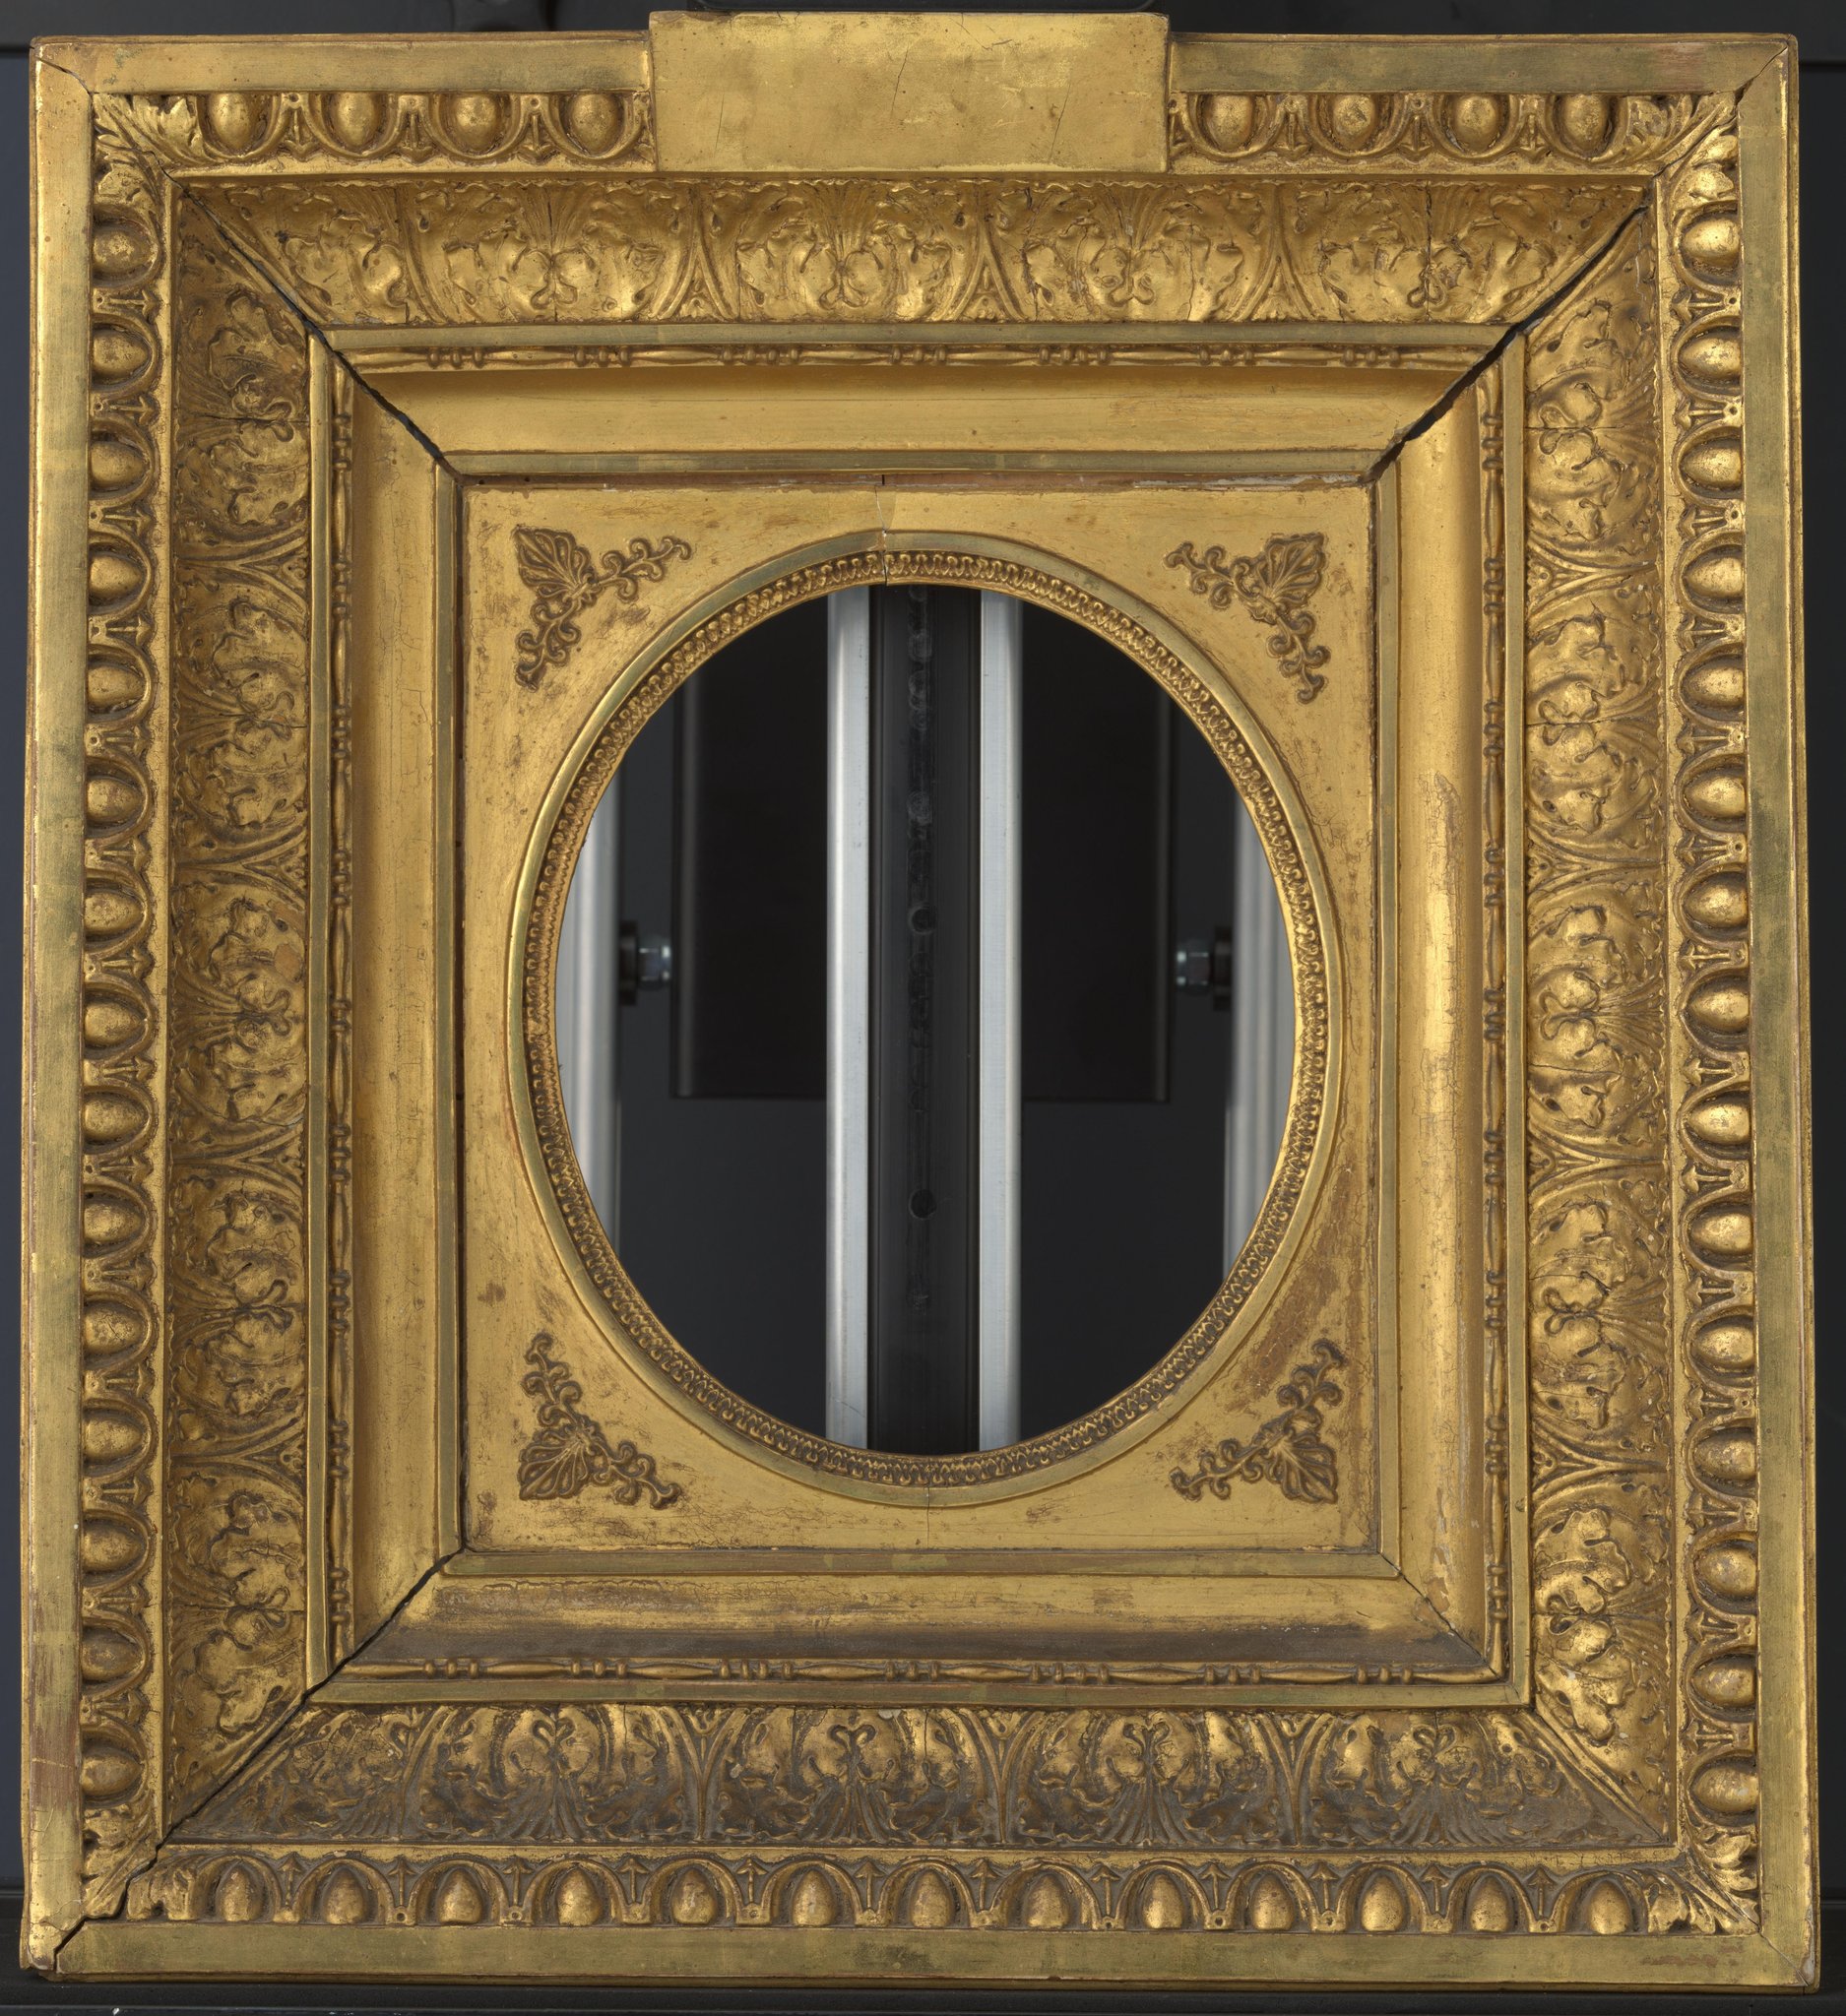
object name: frame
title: Vergulde lijst met pâte ornamenten in neoclassicistische stijl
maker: Anonymous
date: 1800-1849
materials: gold leaf, wood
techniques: gilding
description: Neoklassieke vergulde lijst met pâte ornamenten uit verschillende stijlperioden; Renaissance, Empire en Biedermeier. De dagopening van de binnenlijst is ovaal. De verstekken zijn aan de achterkant verbonden met taps toelopende zwaluwstaart spieën. De binnenlijst is met spijkers bevestigd in de sponning van het buitenste profiel.